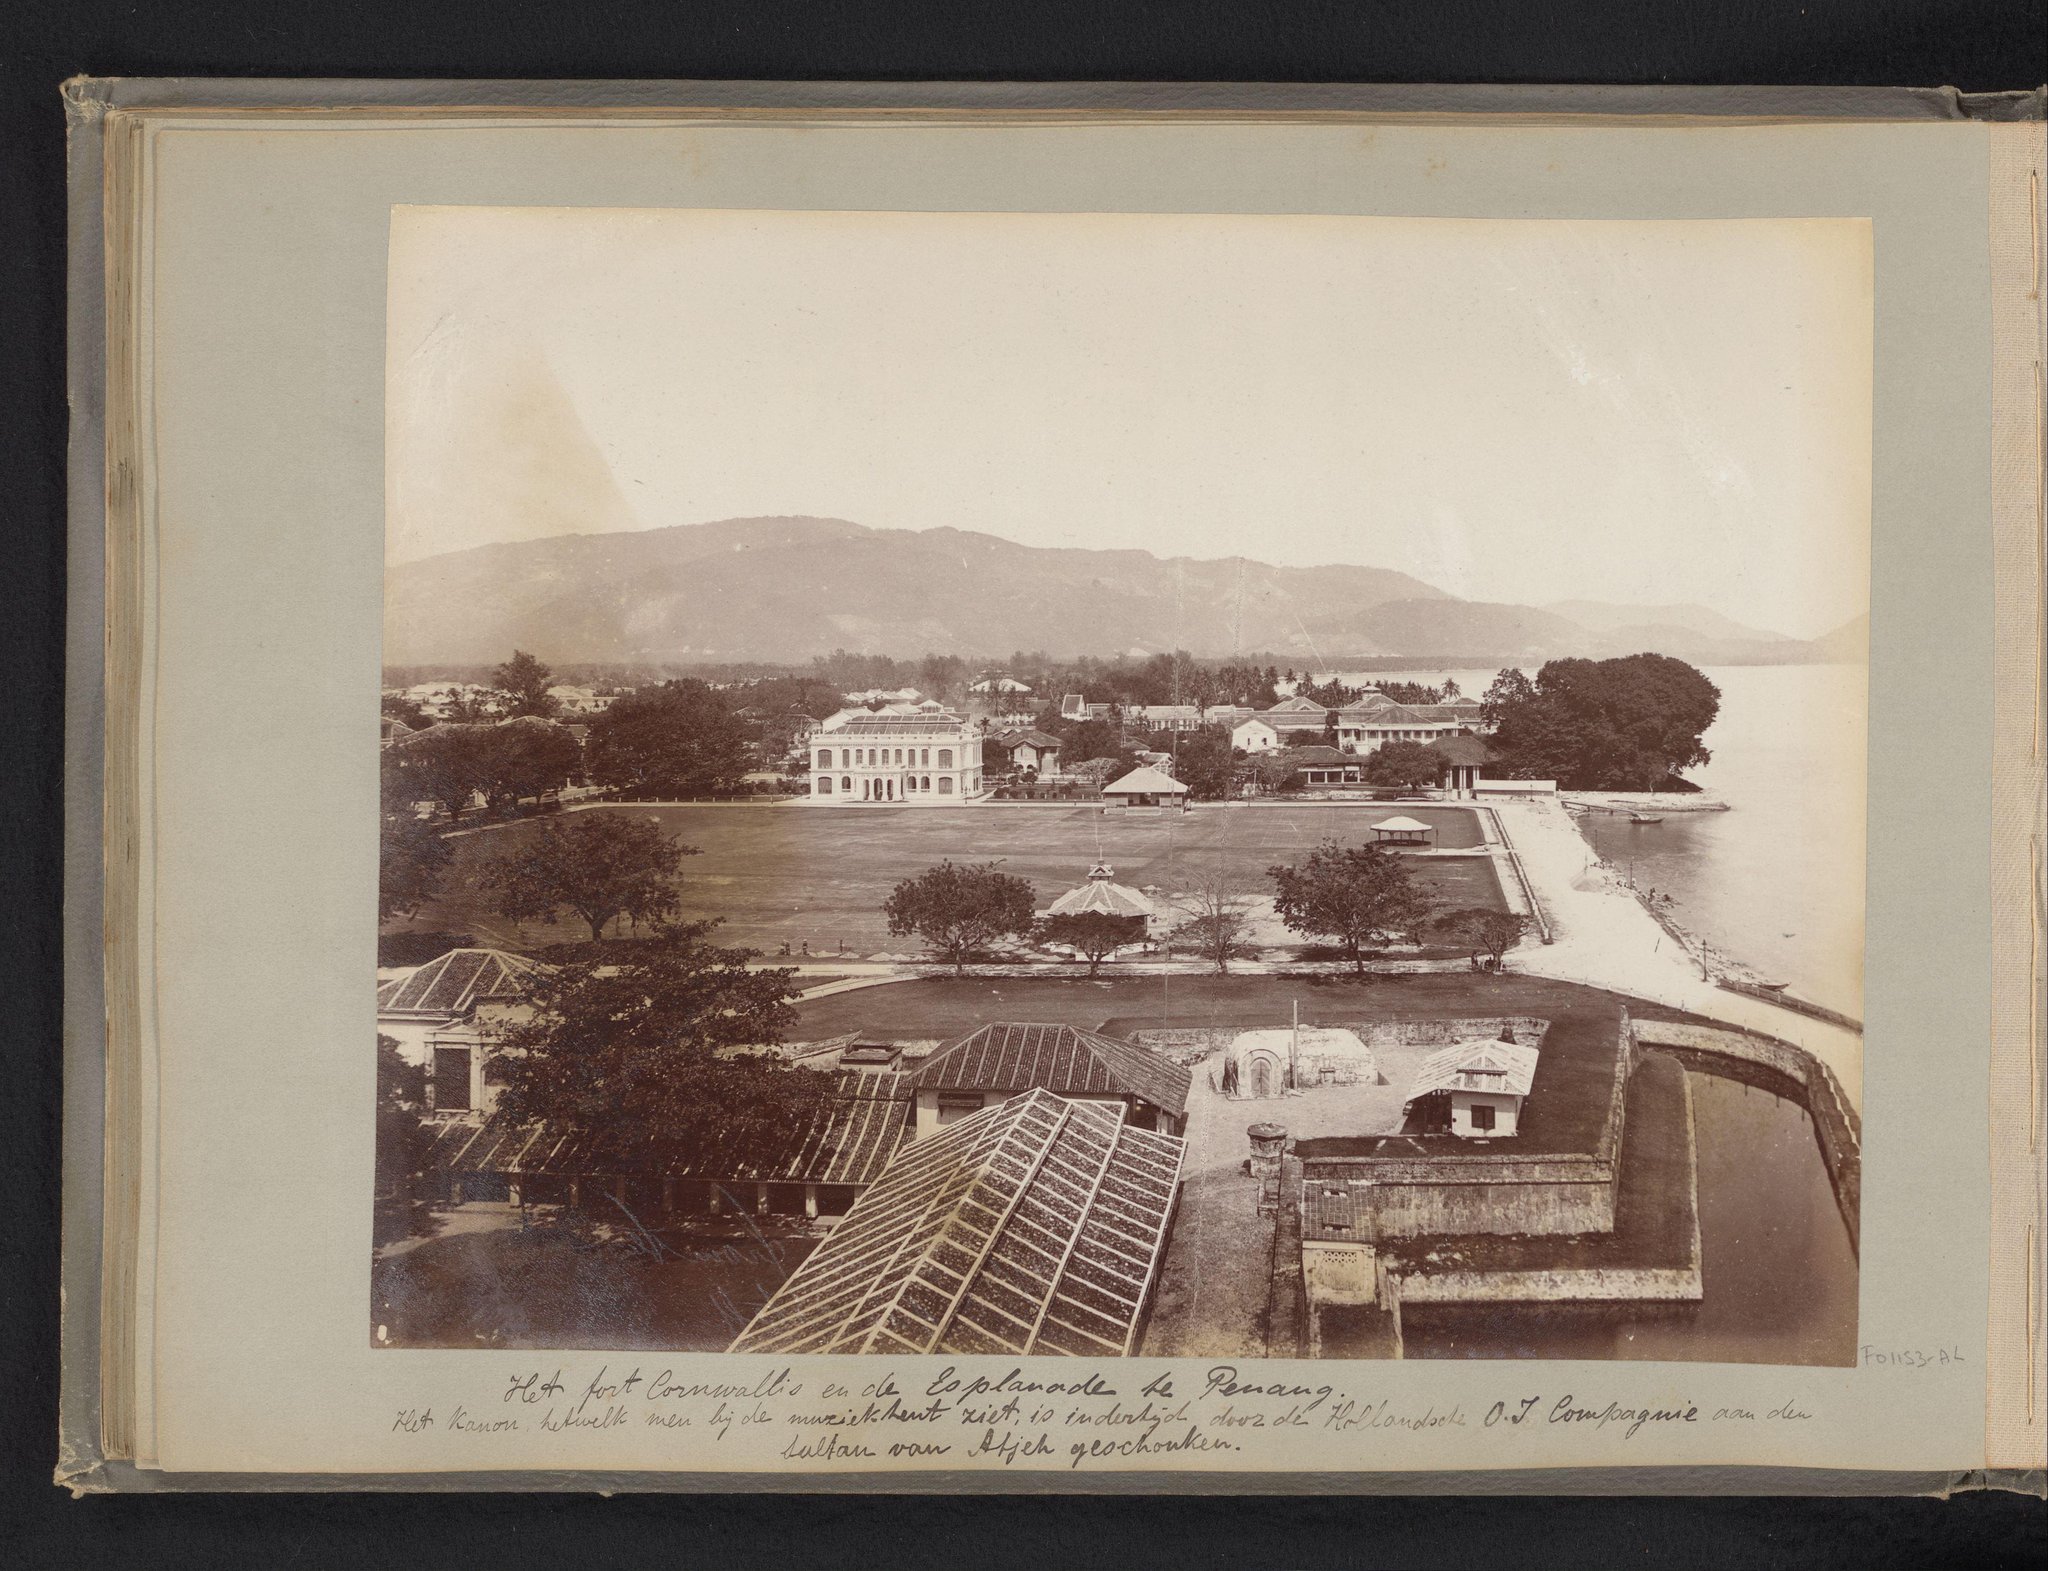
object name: album leaf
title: Het fort Cornwall en de Esplanade te Penang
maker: Anonymous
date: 1892-1893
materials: photographic support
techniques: albumen print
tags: fortress, avenue, boulevard, promenade, esplanade, sumatra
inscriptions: annotation: ‘Het kanon hetwelk men bij de muziektent ziet is indertijd door de Hollandsche O. I. Compagnie aa den / sultan van Atjeh geschonken.’